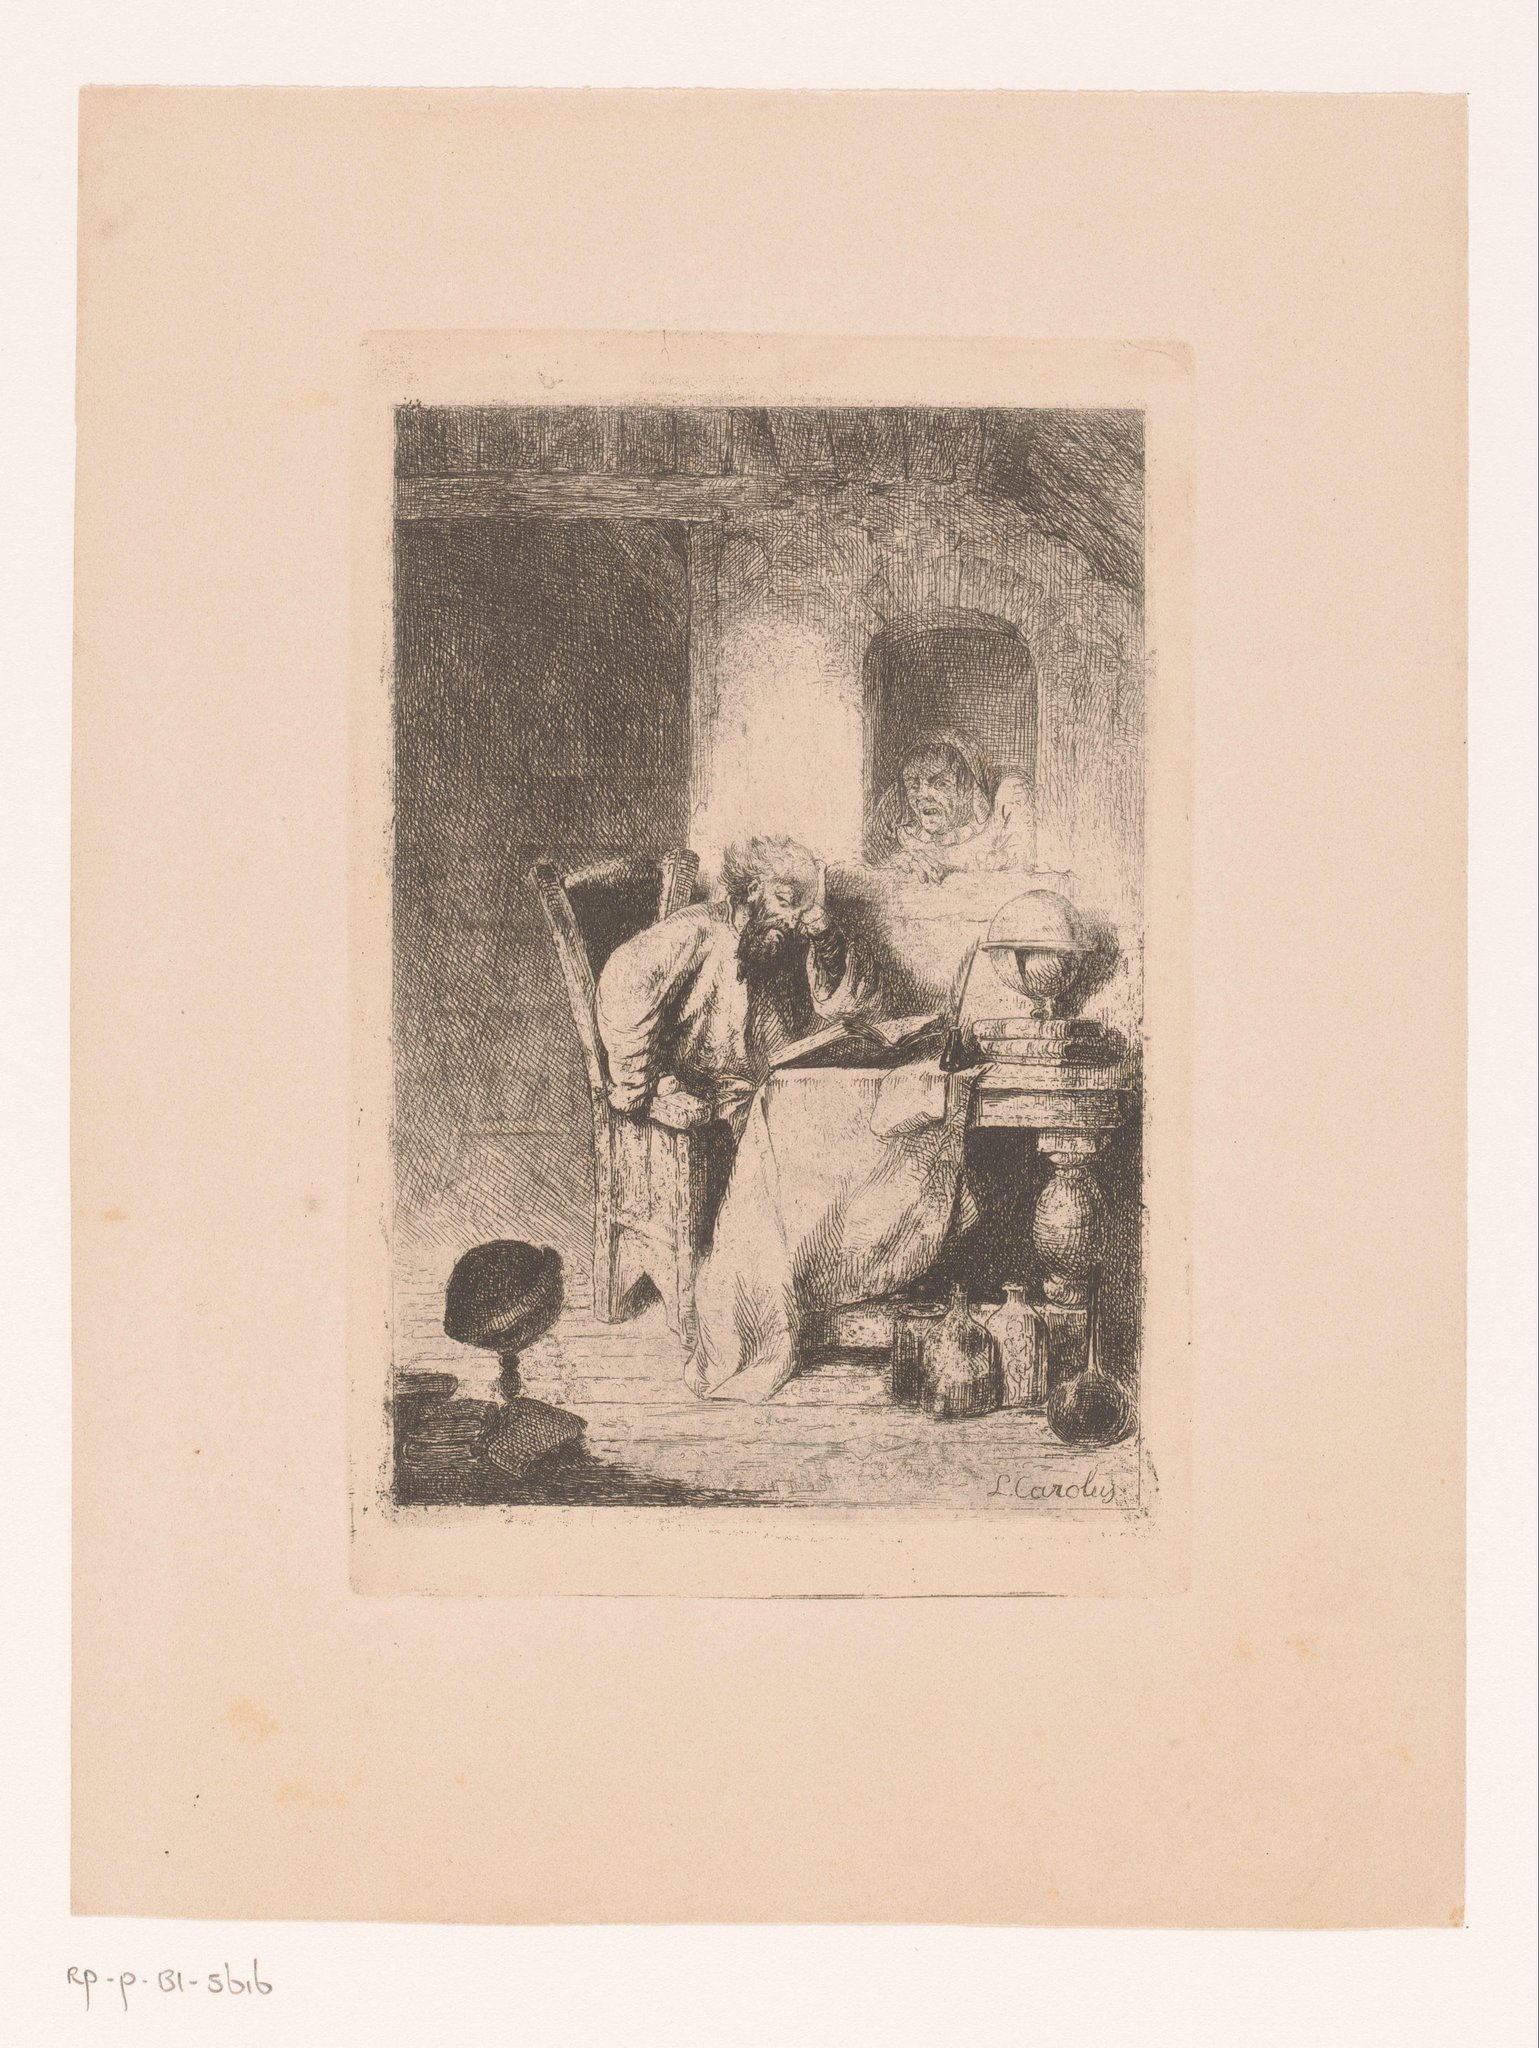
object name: print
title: Filosoof in zijn studeerkamer gestoord door een boze vrouw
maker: louis antoine carolus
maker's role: print maker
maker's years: 1814-1865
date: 1824-1865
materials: paper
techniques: etching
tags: scholar in his study, rage, anger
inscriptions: collector's mark: Lugt 2228